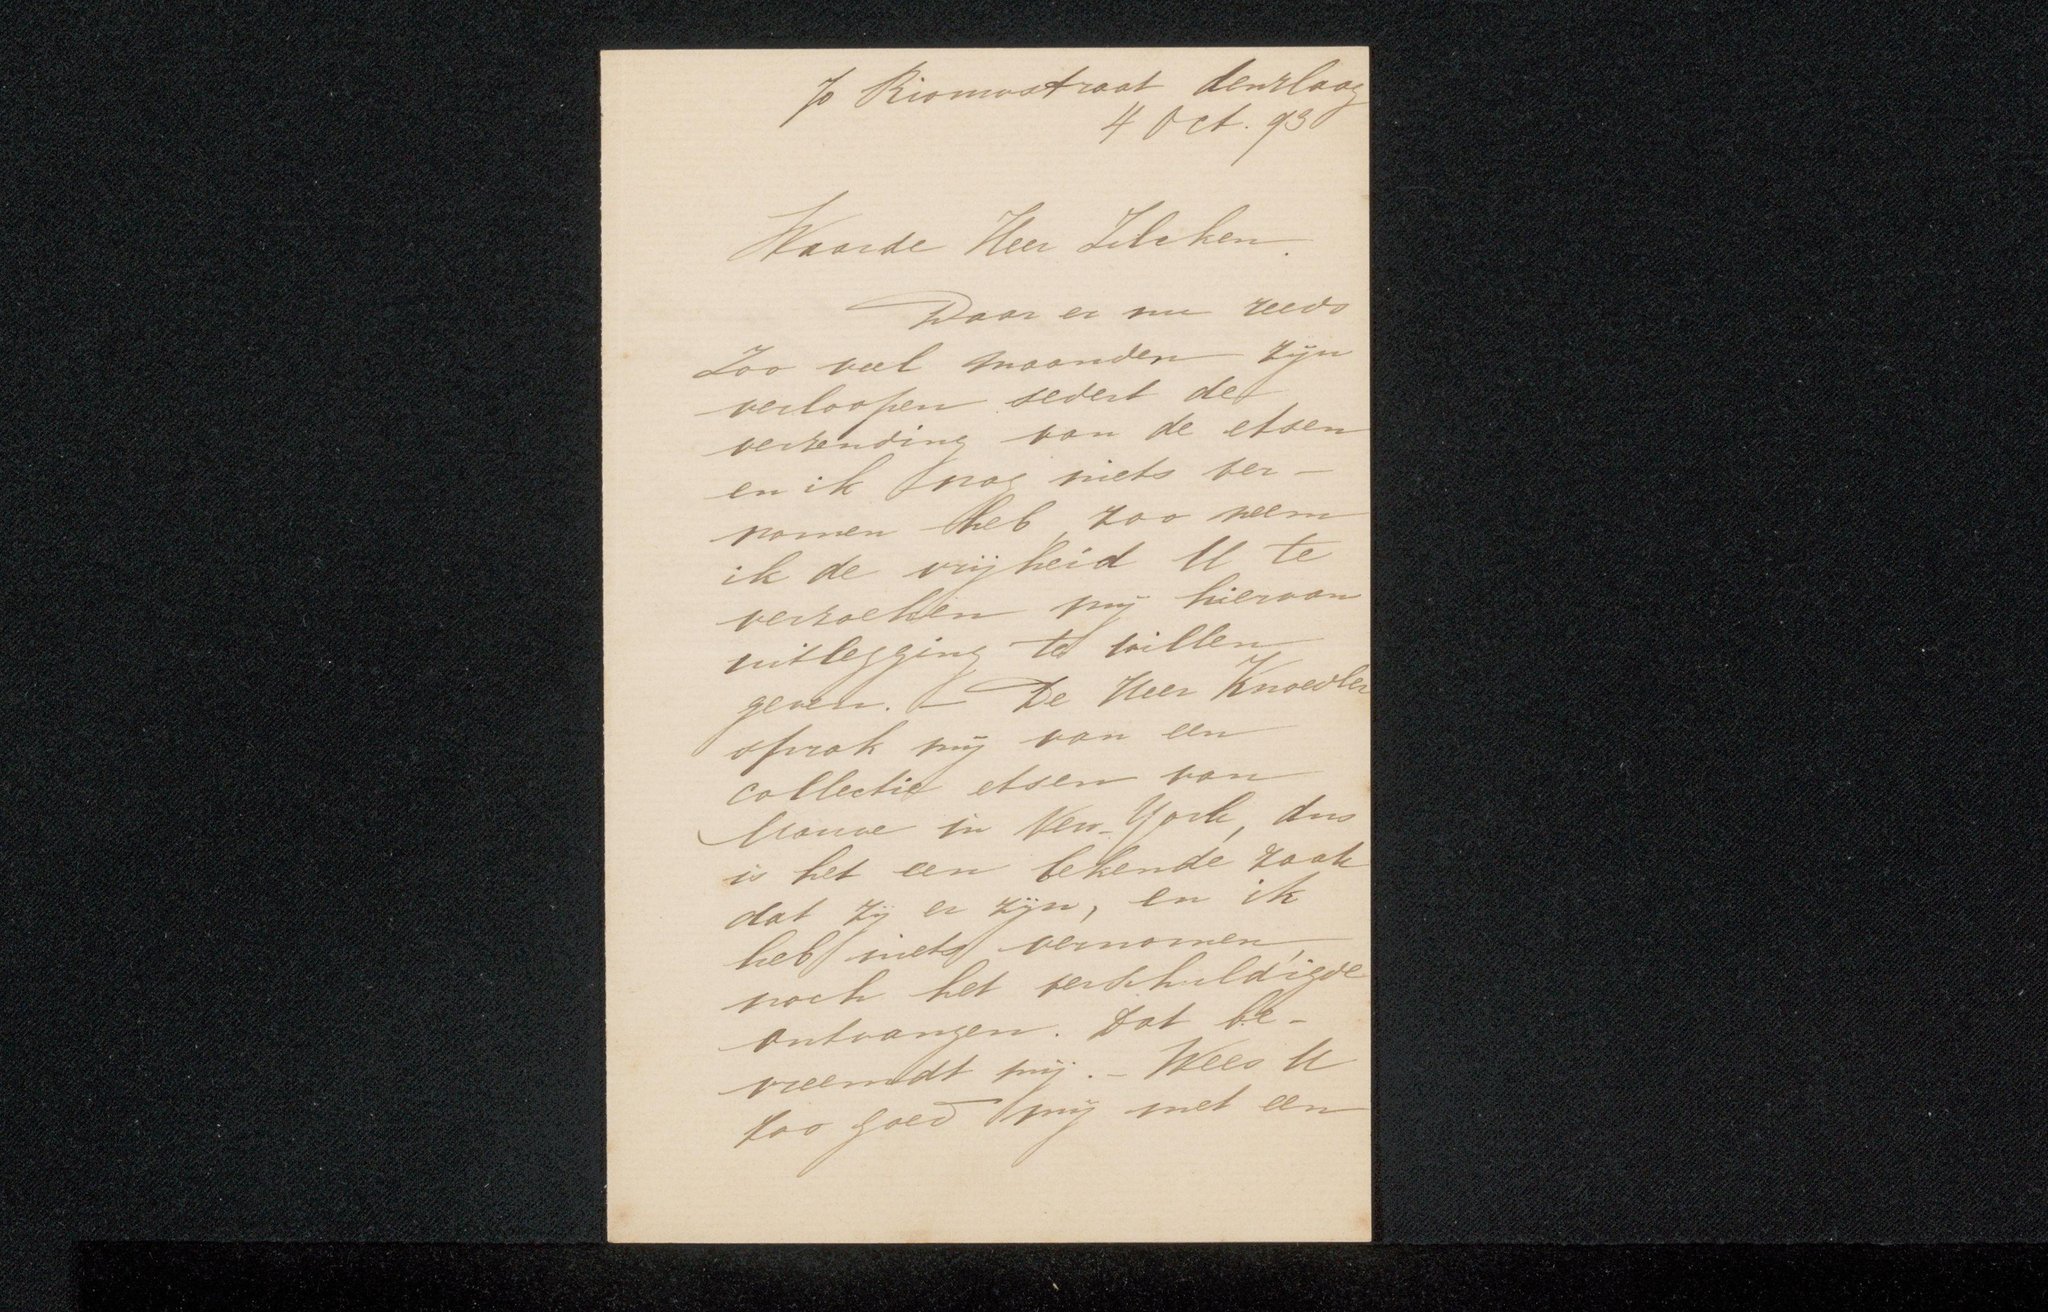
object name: letter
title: Brief aan Philip Zilcken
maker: ariette sophia jeannette mauve-carbentus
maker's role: draughtsman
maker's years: 1856-1894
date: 1893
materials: ink, paper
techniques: pen, writing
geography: the hague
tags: arnhem, painter, print maker, draughtsman, anton mauve, philip zilcken, sending and receiving postal matter, the graphic arts, money, new york (city)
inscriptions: collector's mark: ‘RPK’